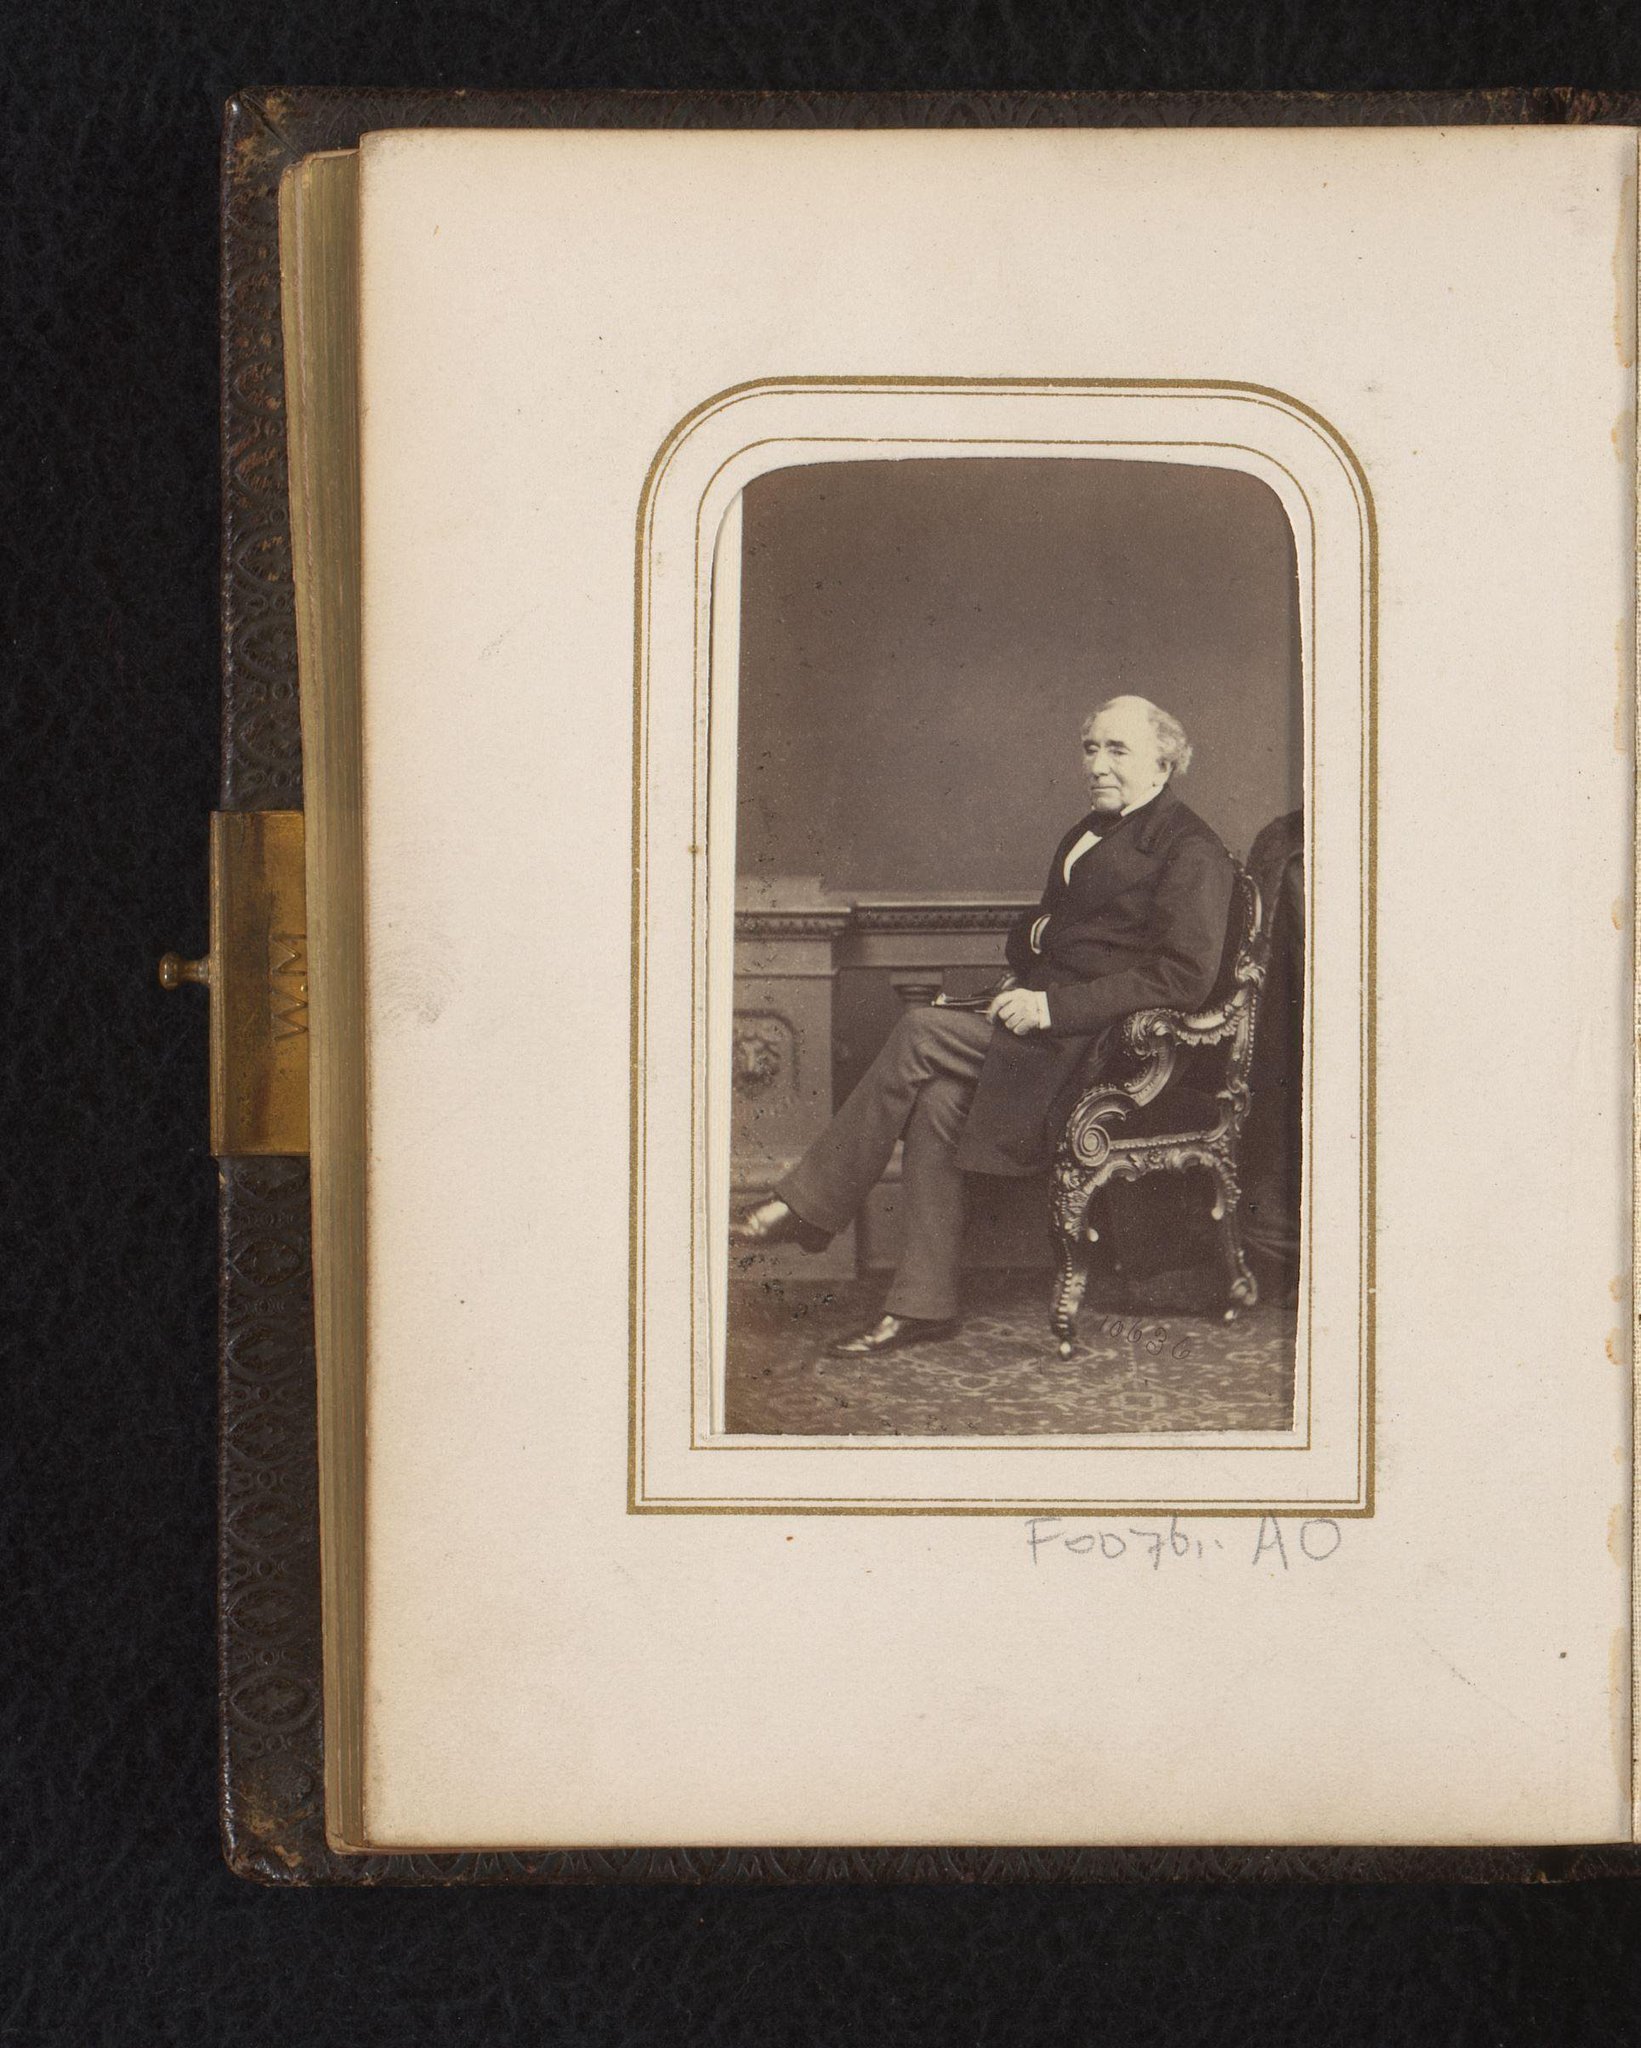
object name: carte de visite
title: Portret van een zittende man met handschoenen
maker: john jabez edwin mayall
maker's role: fotograaf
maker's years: 1813-1901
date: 1850-1860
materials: cardboard, photographic support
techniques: albumen print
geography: london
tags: gloves, mittens, etc., historical persons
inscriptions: inscription: ‘Photographed from life by/ Mayall/ 224, Regent Street/ London/ 90, King's Road/ Brighton’